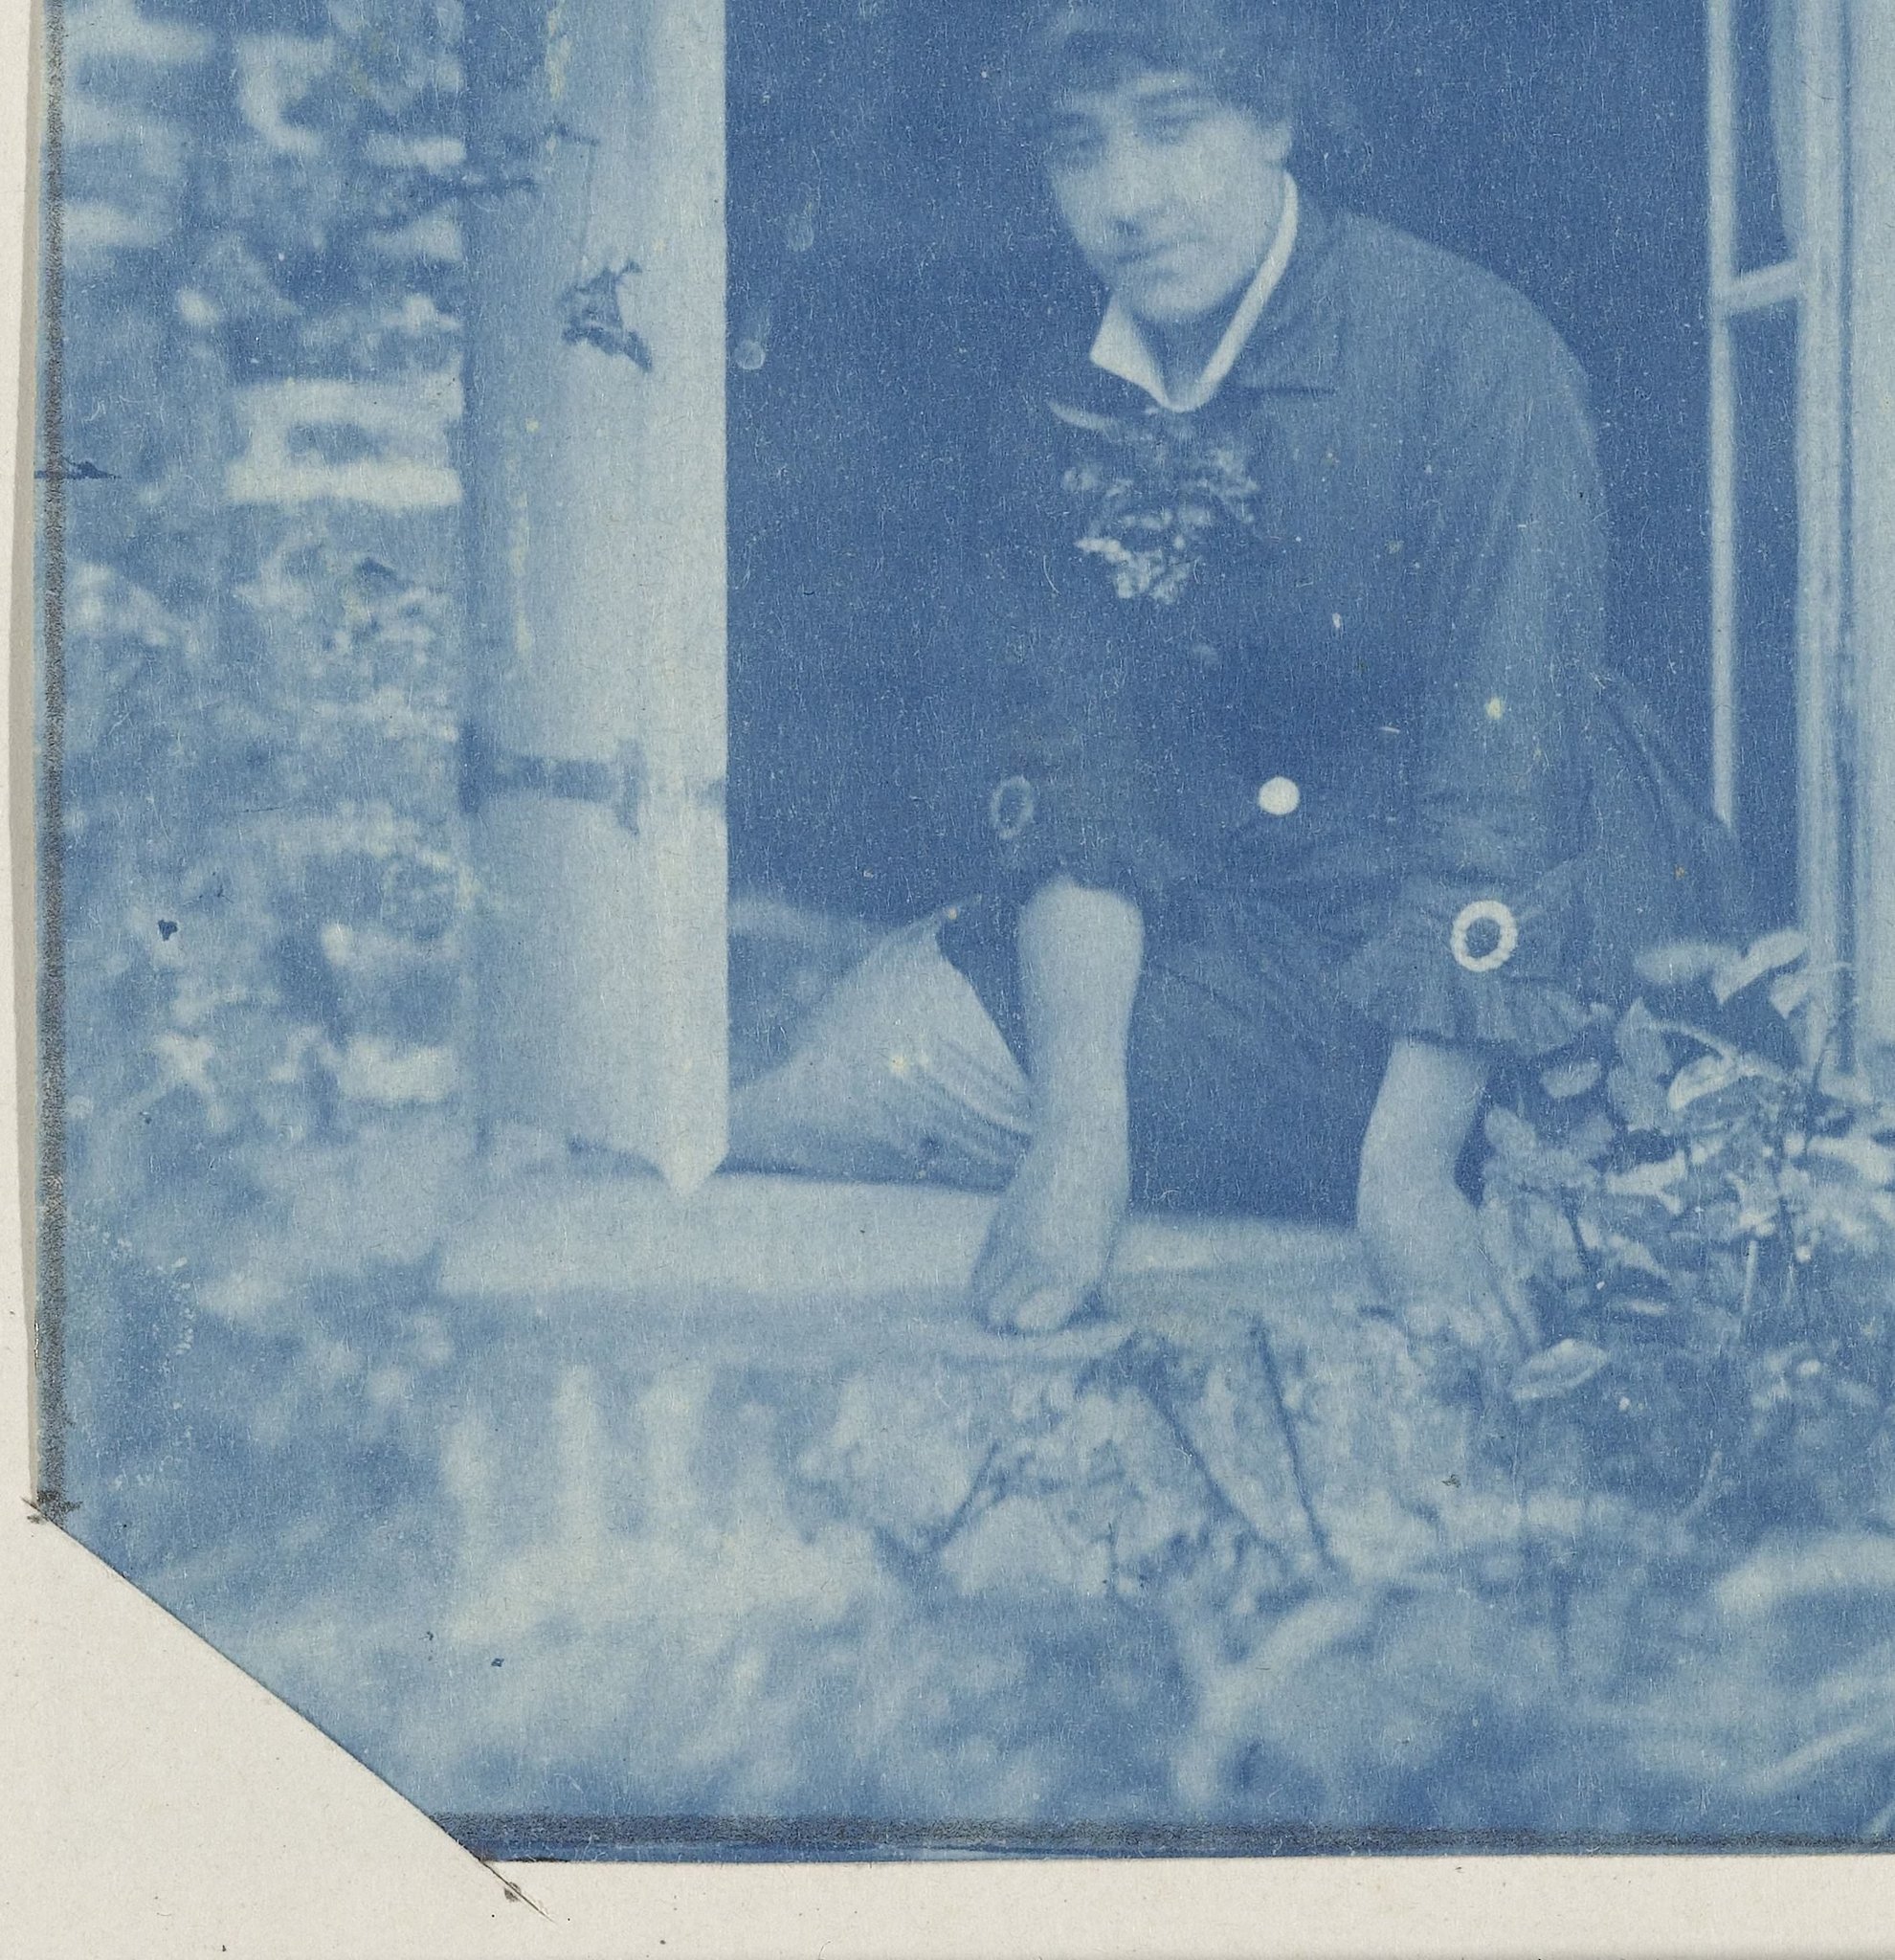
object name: photograph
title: Portret van een onbekende vrouw in een venster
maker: Anonymous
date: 1878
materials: paper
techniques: cyanotype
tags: historical persons - bb - woman, open window, france